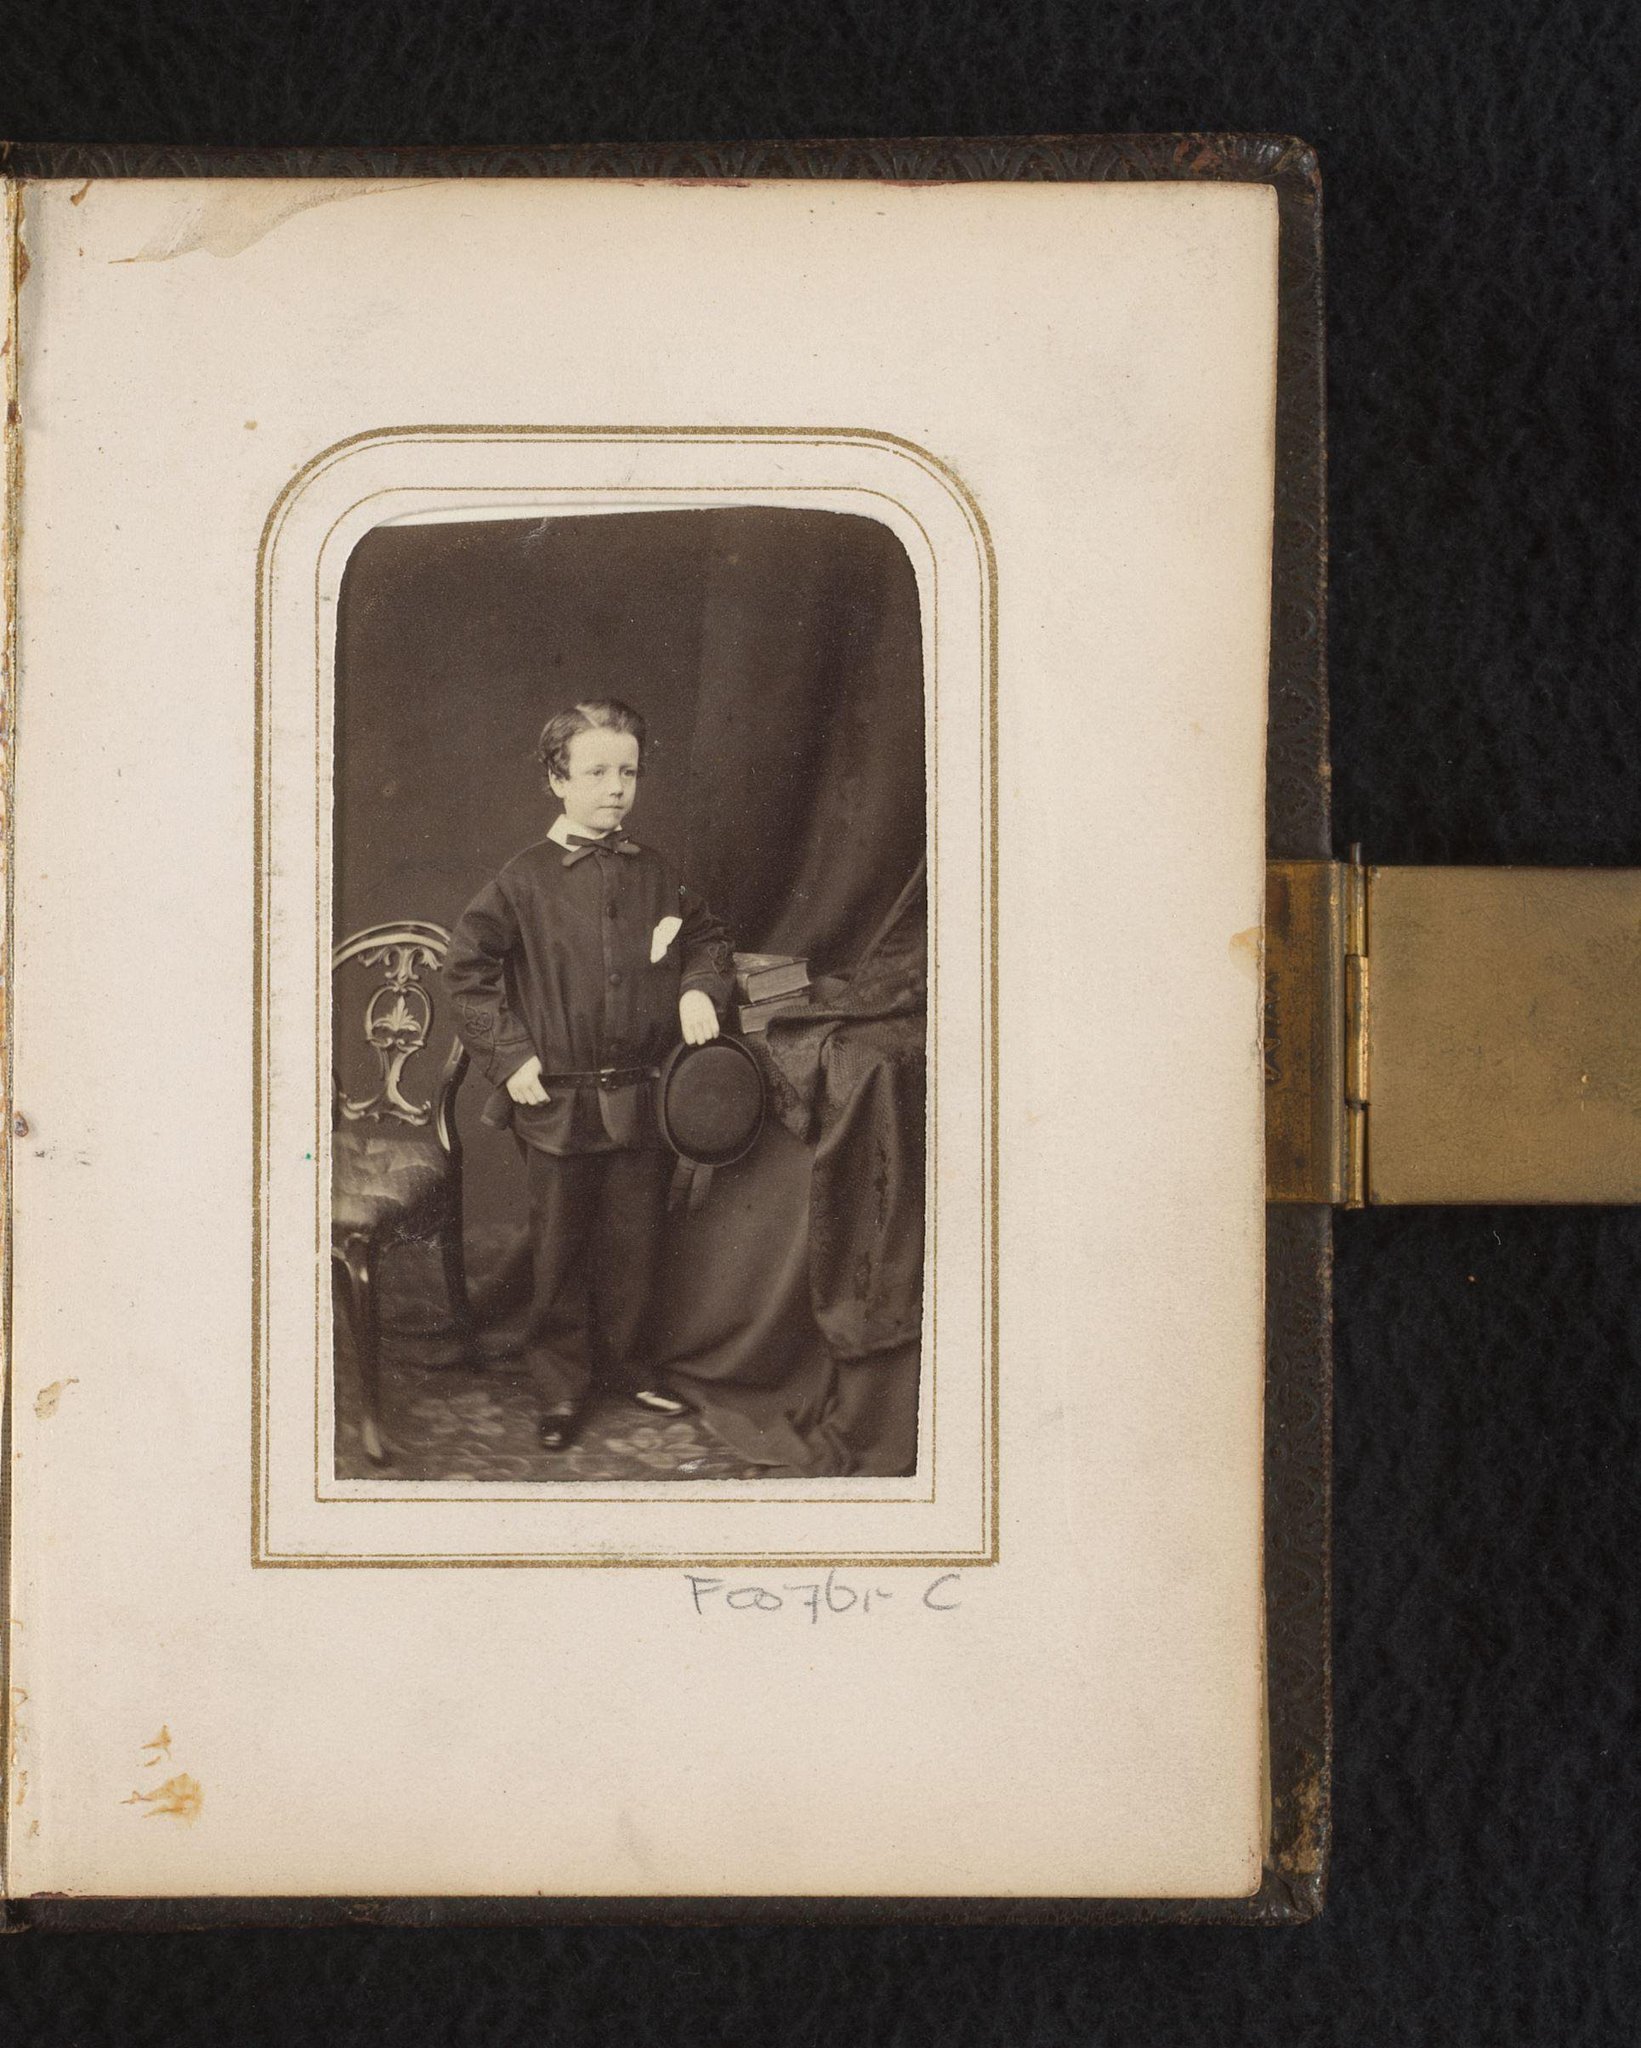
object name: album leaf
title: Portret van een jongen met hoed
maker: messrs. white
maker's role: fotograaf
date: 1860-1880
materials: cardboard, photographic support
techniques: albumen print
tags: boy (child between toddler and youth), head-gear: hat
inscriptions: inscription: ‘69 East St.Brighton’